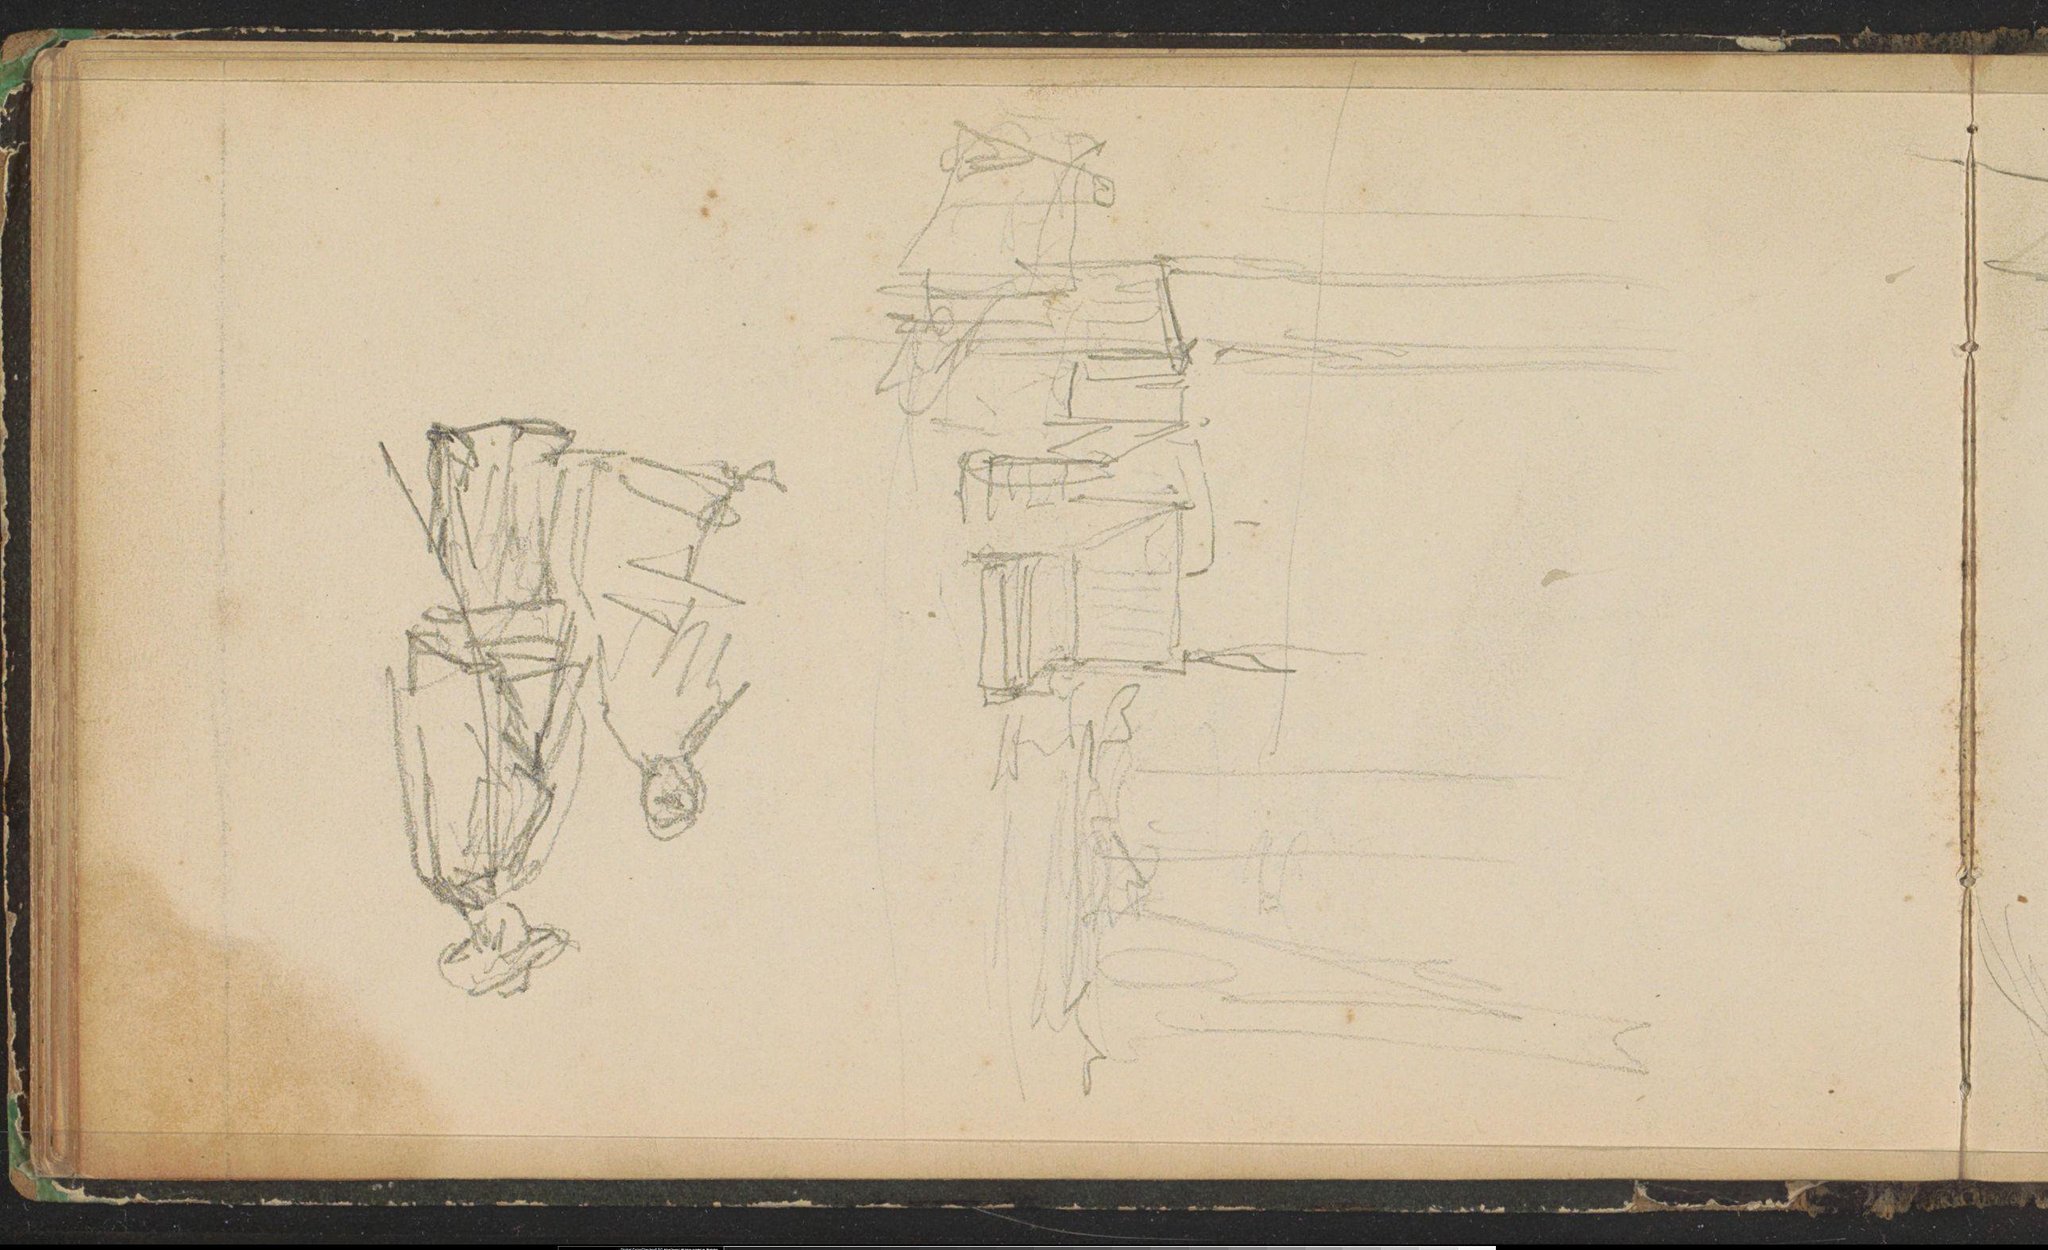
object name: sketchbook leaf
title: Trap of bank in een kerk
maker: johannes bosboom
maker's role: draughtsman, painter, print maker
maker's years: 1817-1891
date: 1845-1891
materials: paper, pencil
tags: standing figure (+ female (human being) (not to be used where -aa- is prescribed)), parts of church interior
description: Tevens een studie van een vrouw met hoed naast een kind. Blad 30 verso uit een schetsboek met 46 bladen.